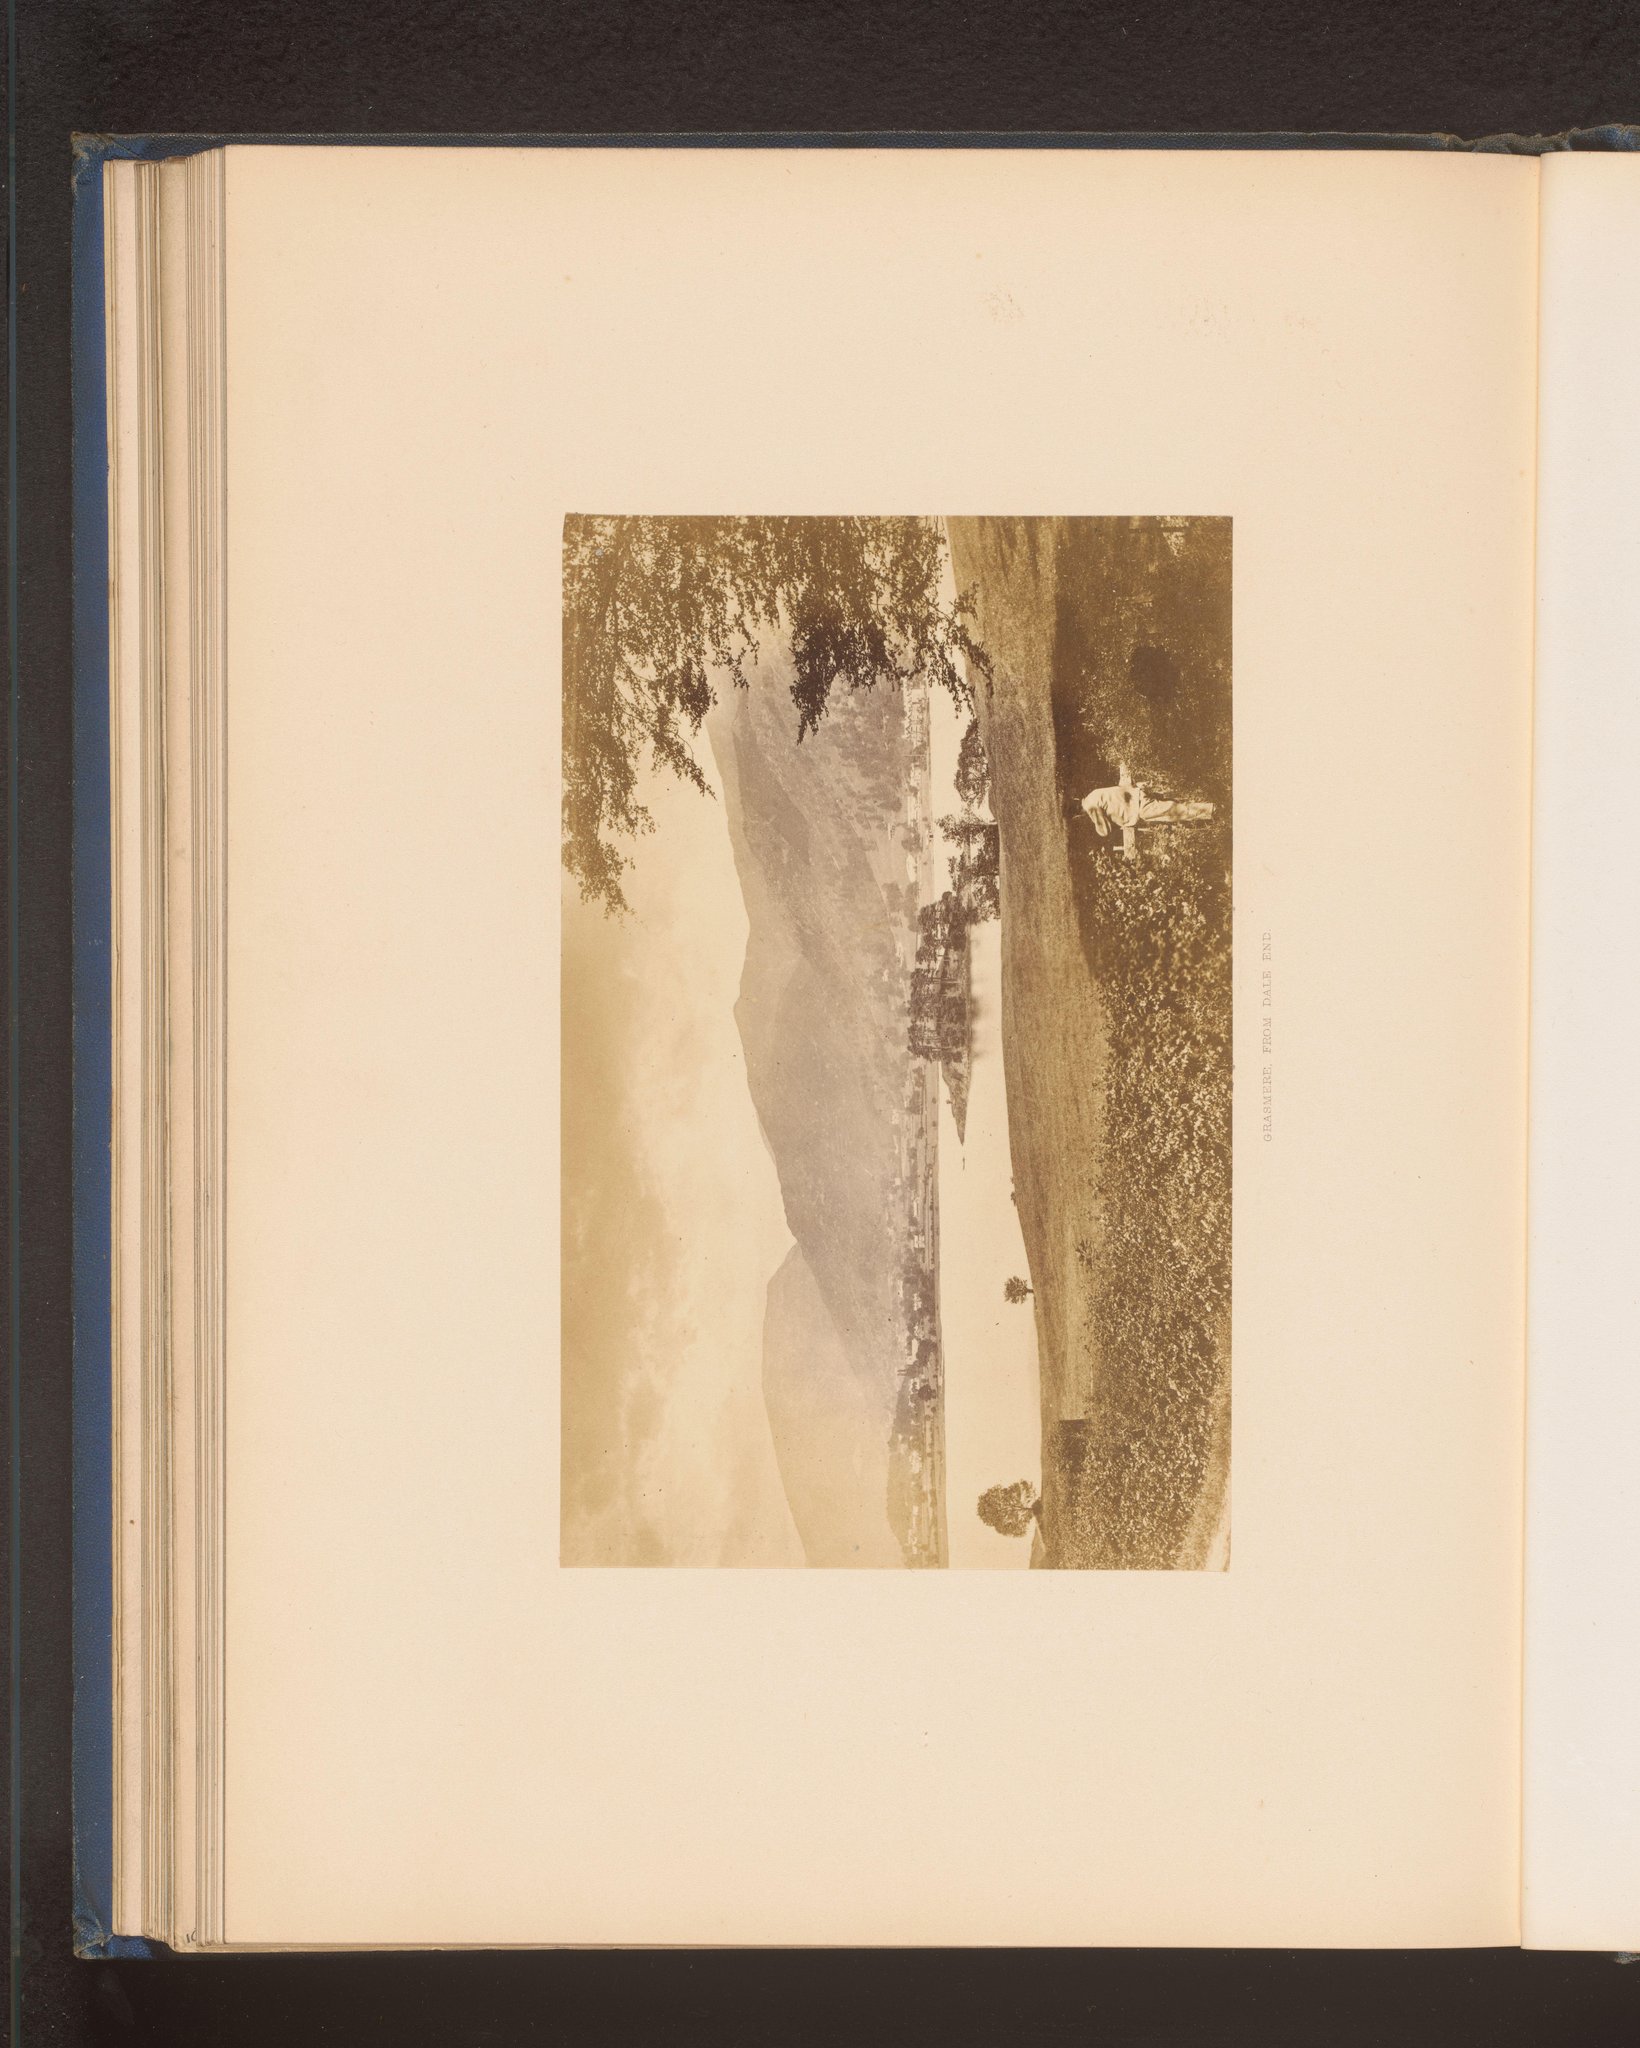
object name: page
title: Grasmere, from dale end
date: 1857-1867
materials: photographic support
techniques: albumen print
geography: grasmere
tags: lake, mountains